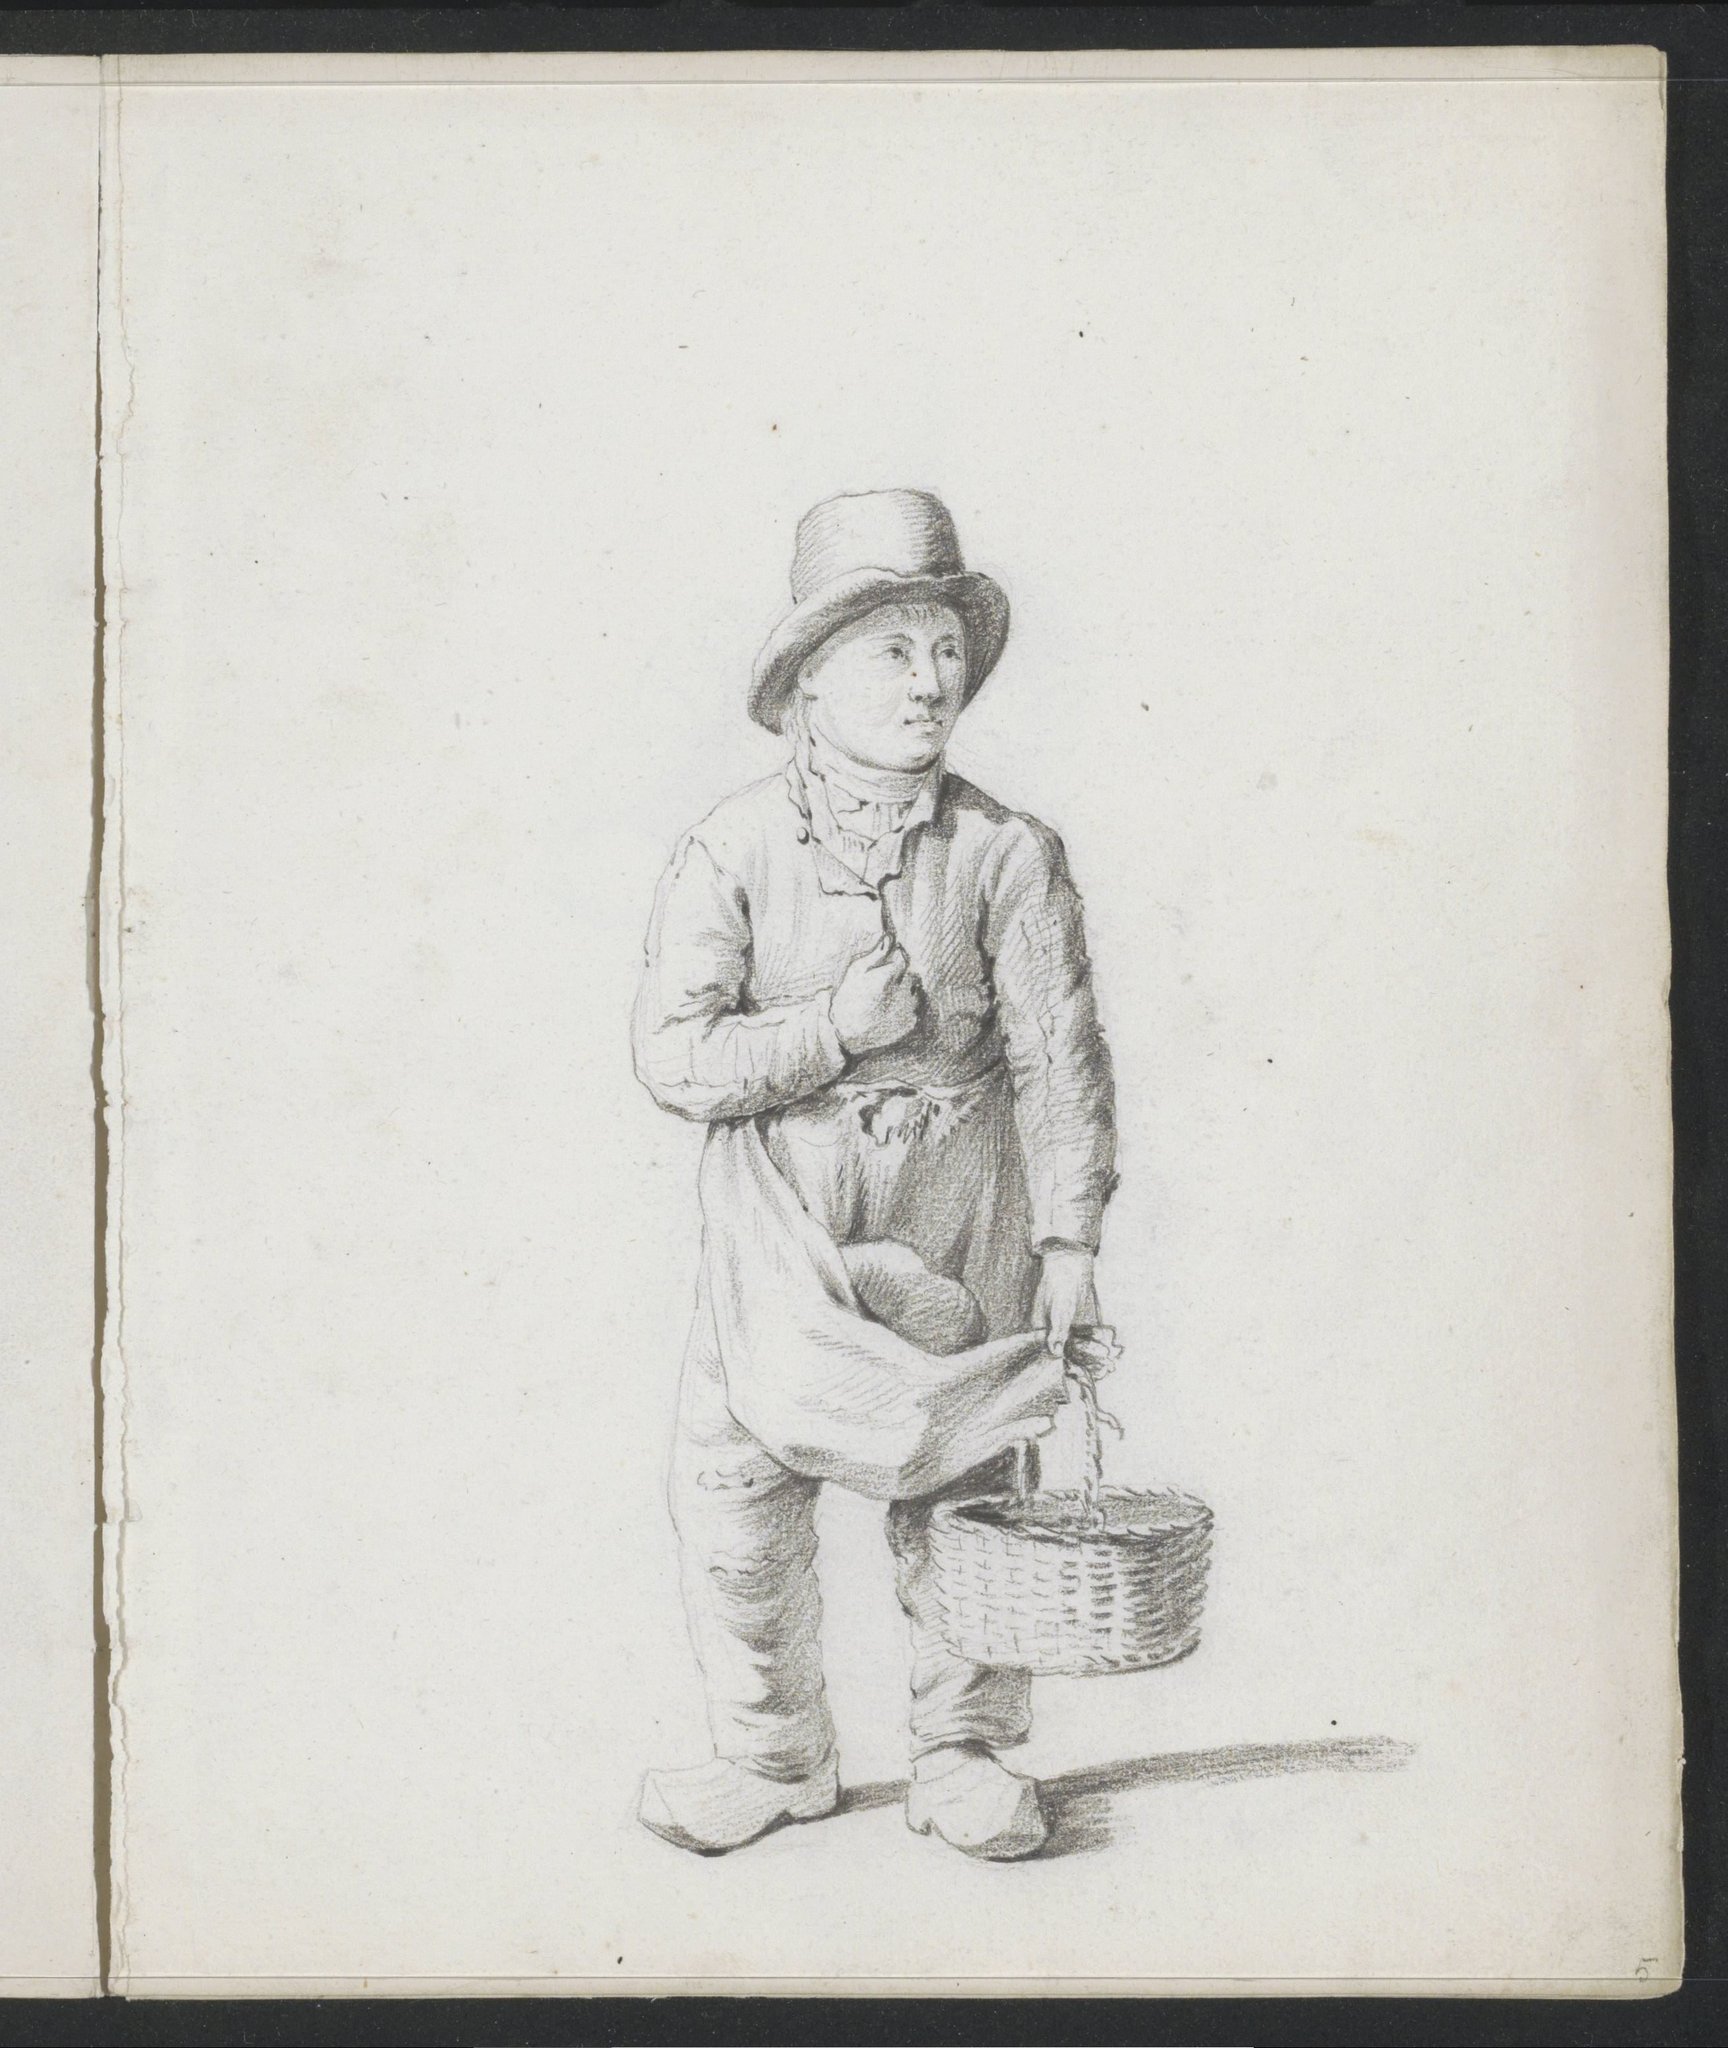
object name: sketchbook leaf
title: Jongen op klompen met rieten mand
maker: balthasar paul ommeganck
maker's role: draughtsman, painter, print maker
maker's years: 1755-1826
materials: chalk, paper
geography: antwerp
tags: boy (child between toddler and youth), carrying something in basket, bag, rucksack, etc.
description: De jongen draagt een hoed en versleten kleren en heeft een draagdoek om zijn middel. Blad 5 recto uit een schetsboek met 8 bladen.